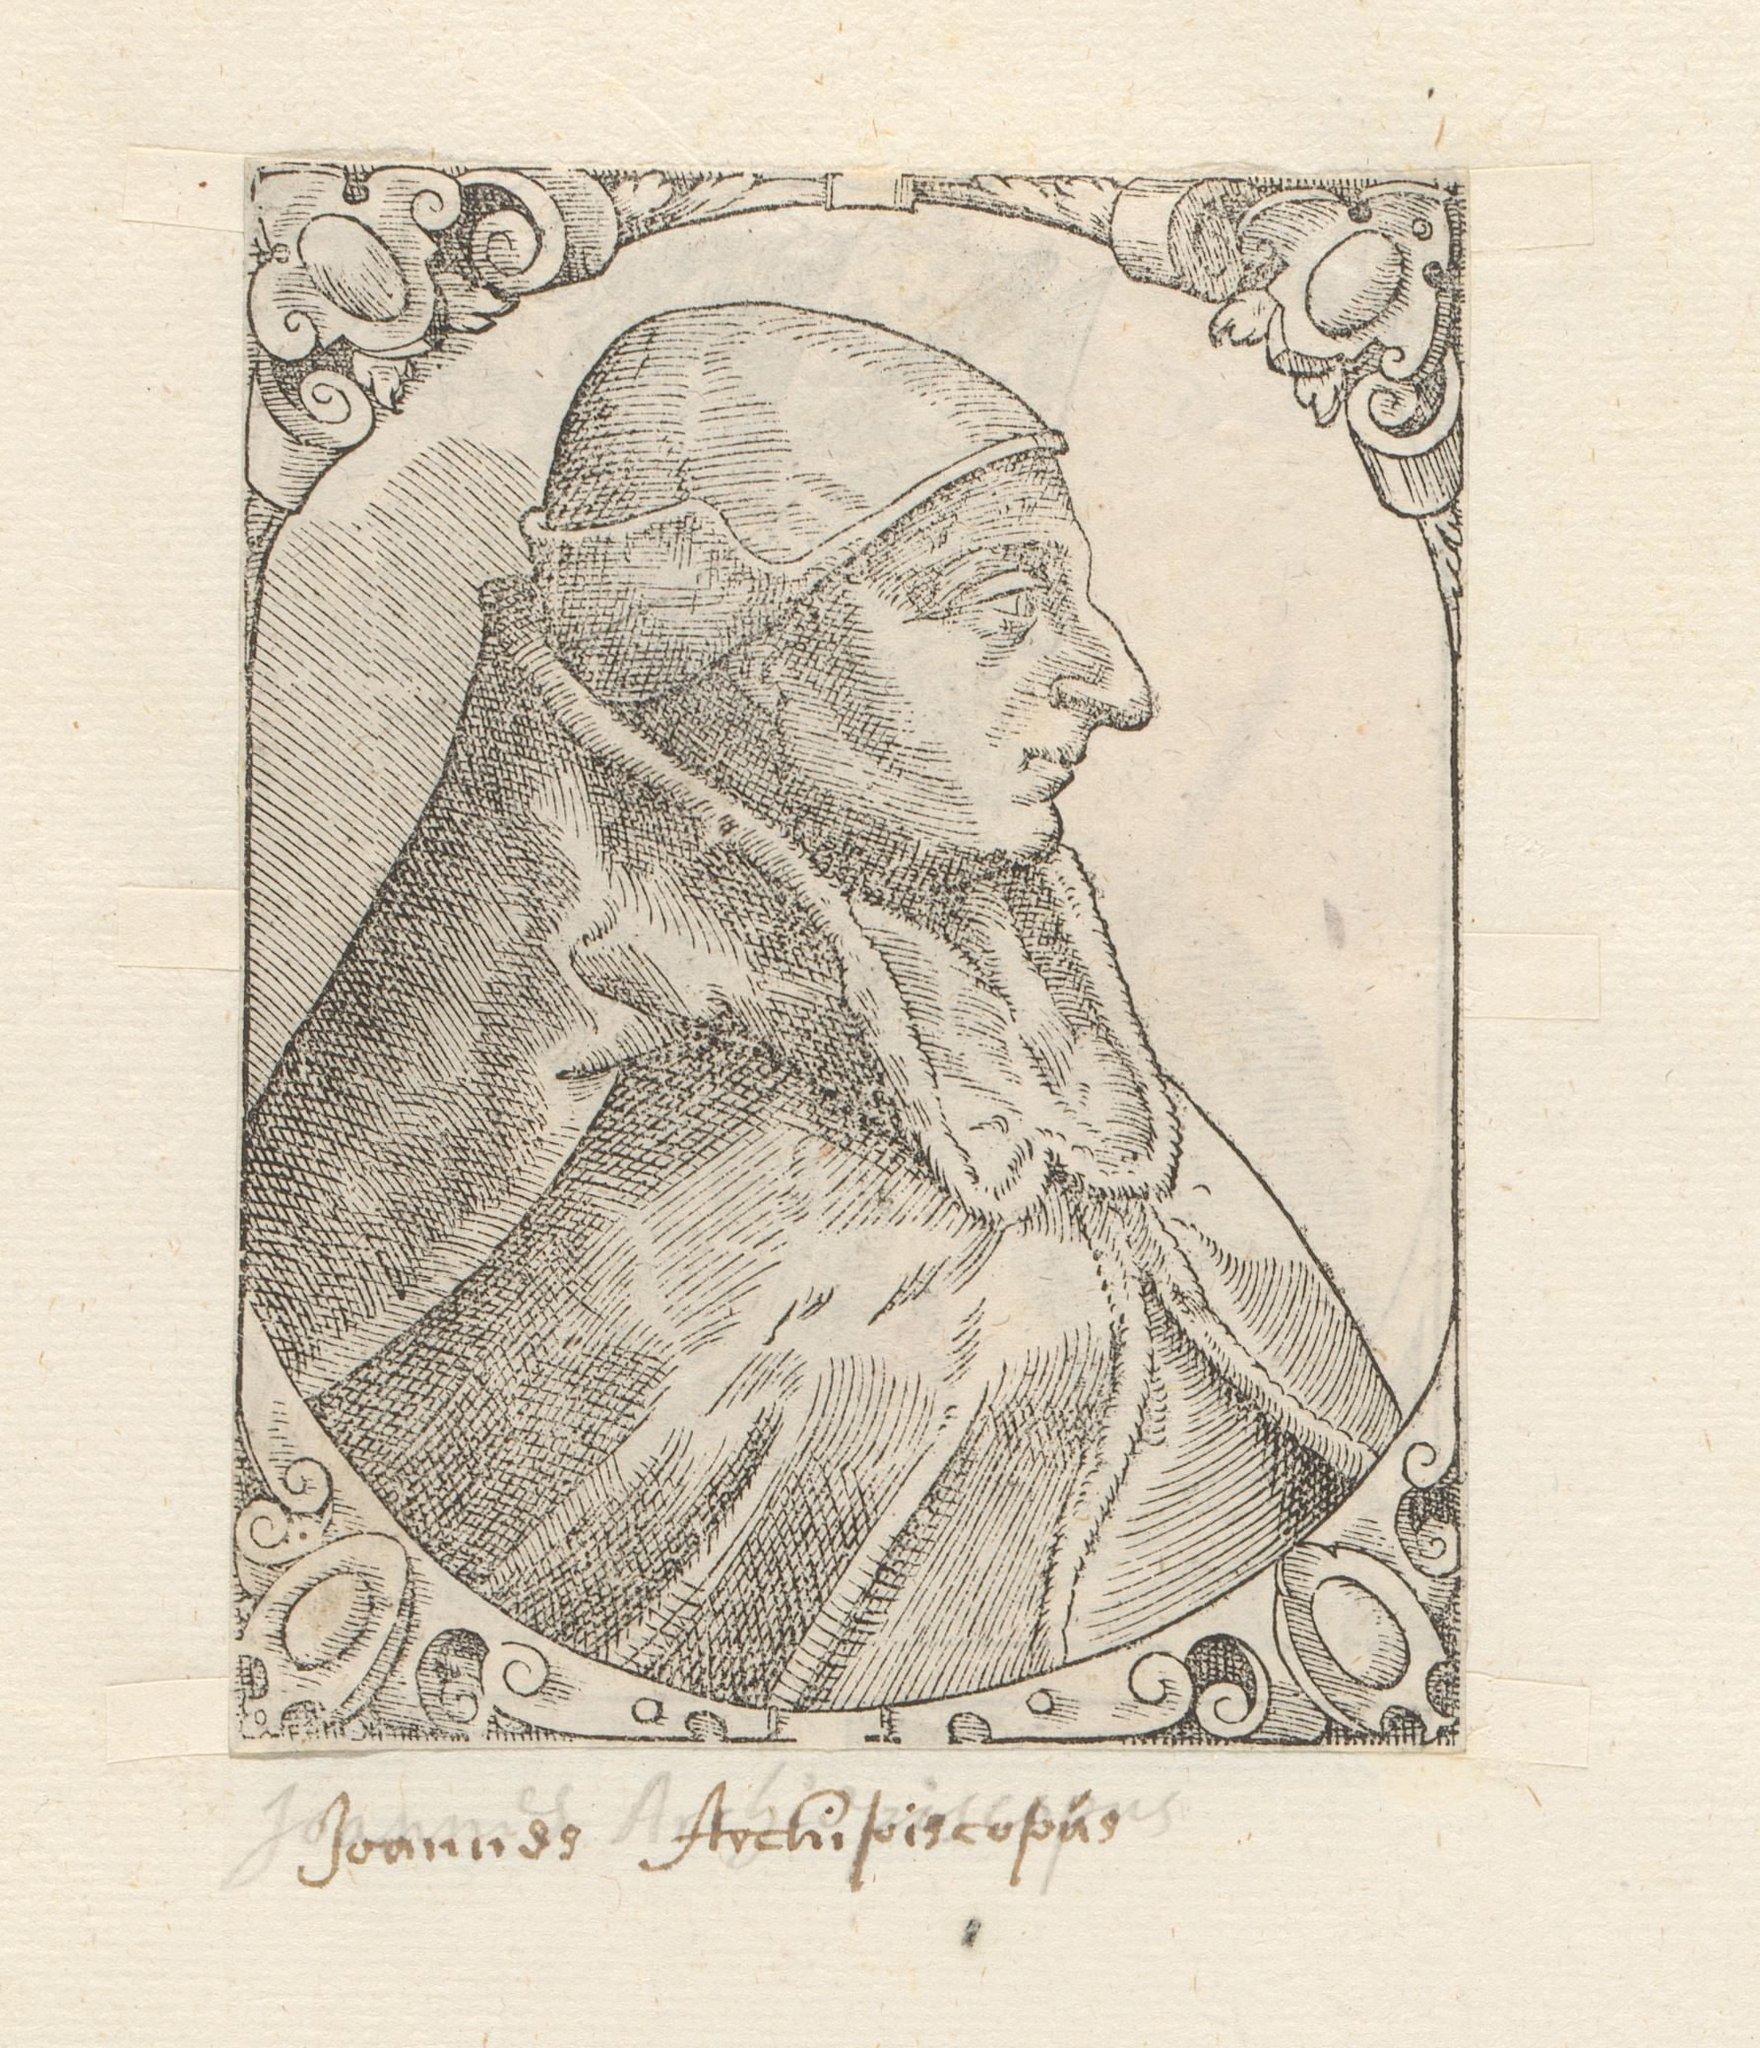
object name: book illustration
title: Portret van Giovanni Visconti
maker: Anonymous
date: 1549-1575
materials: paper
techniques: woodcut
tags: archbishop, bishop, etc. (roman catholic), historical persons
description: Prent gebruikt in: Giovio, Paolo. Elogia Virorum bellica virtute illustrium (...). Bazel: Peter Perna, 1575.